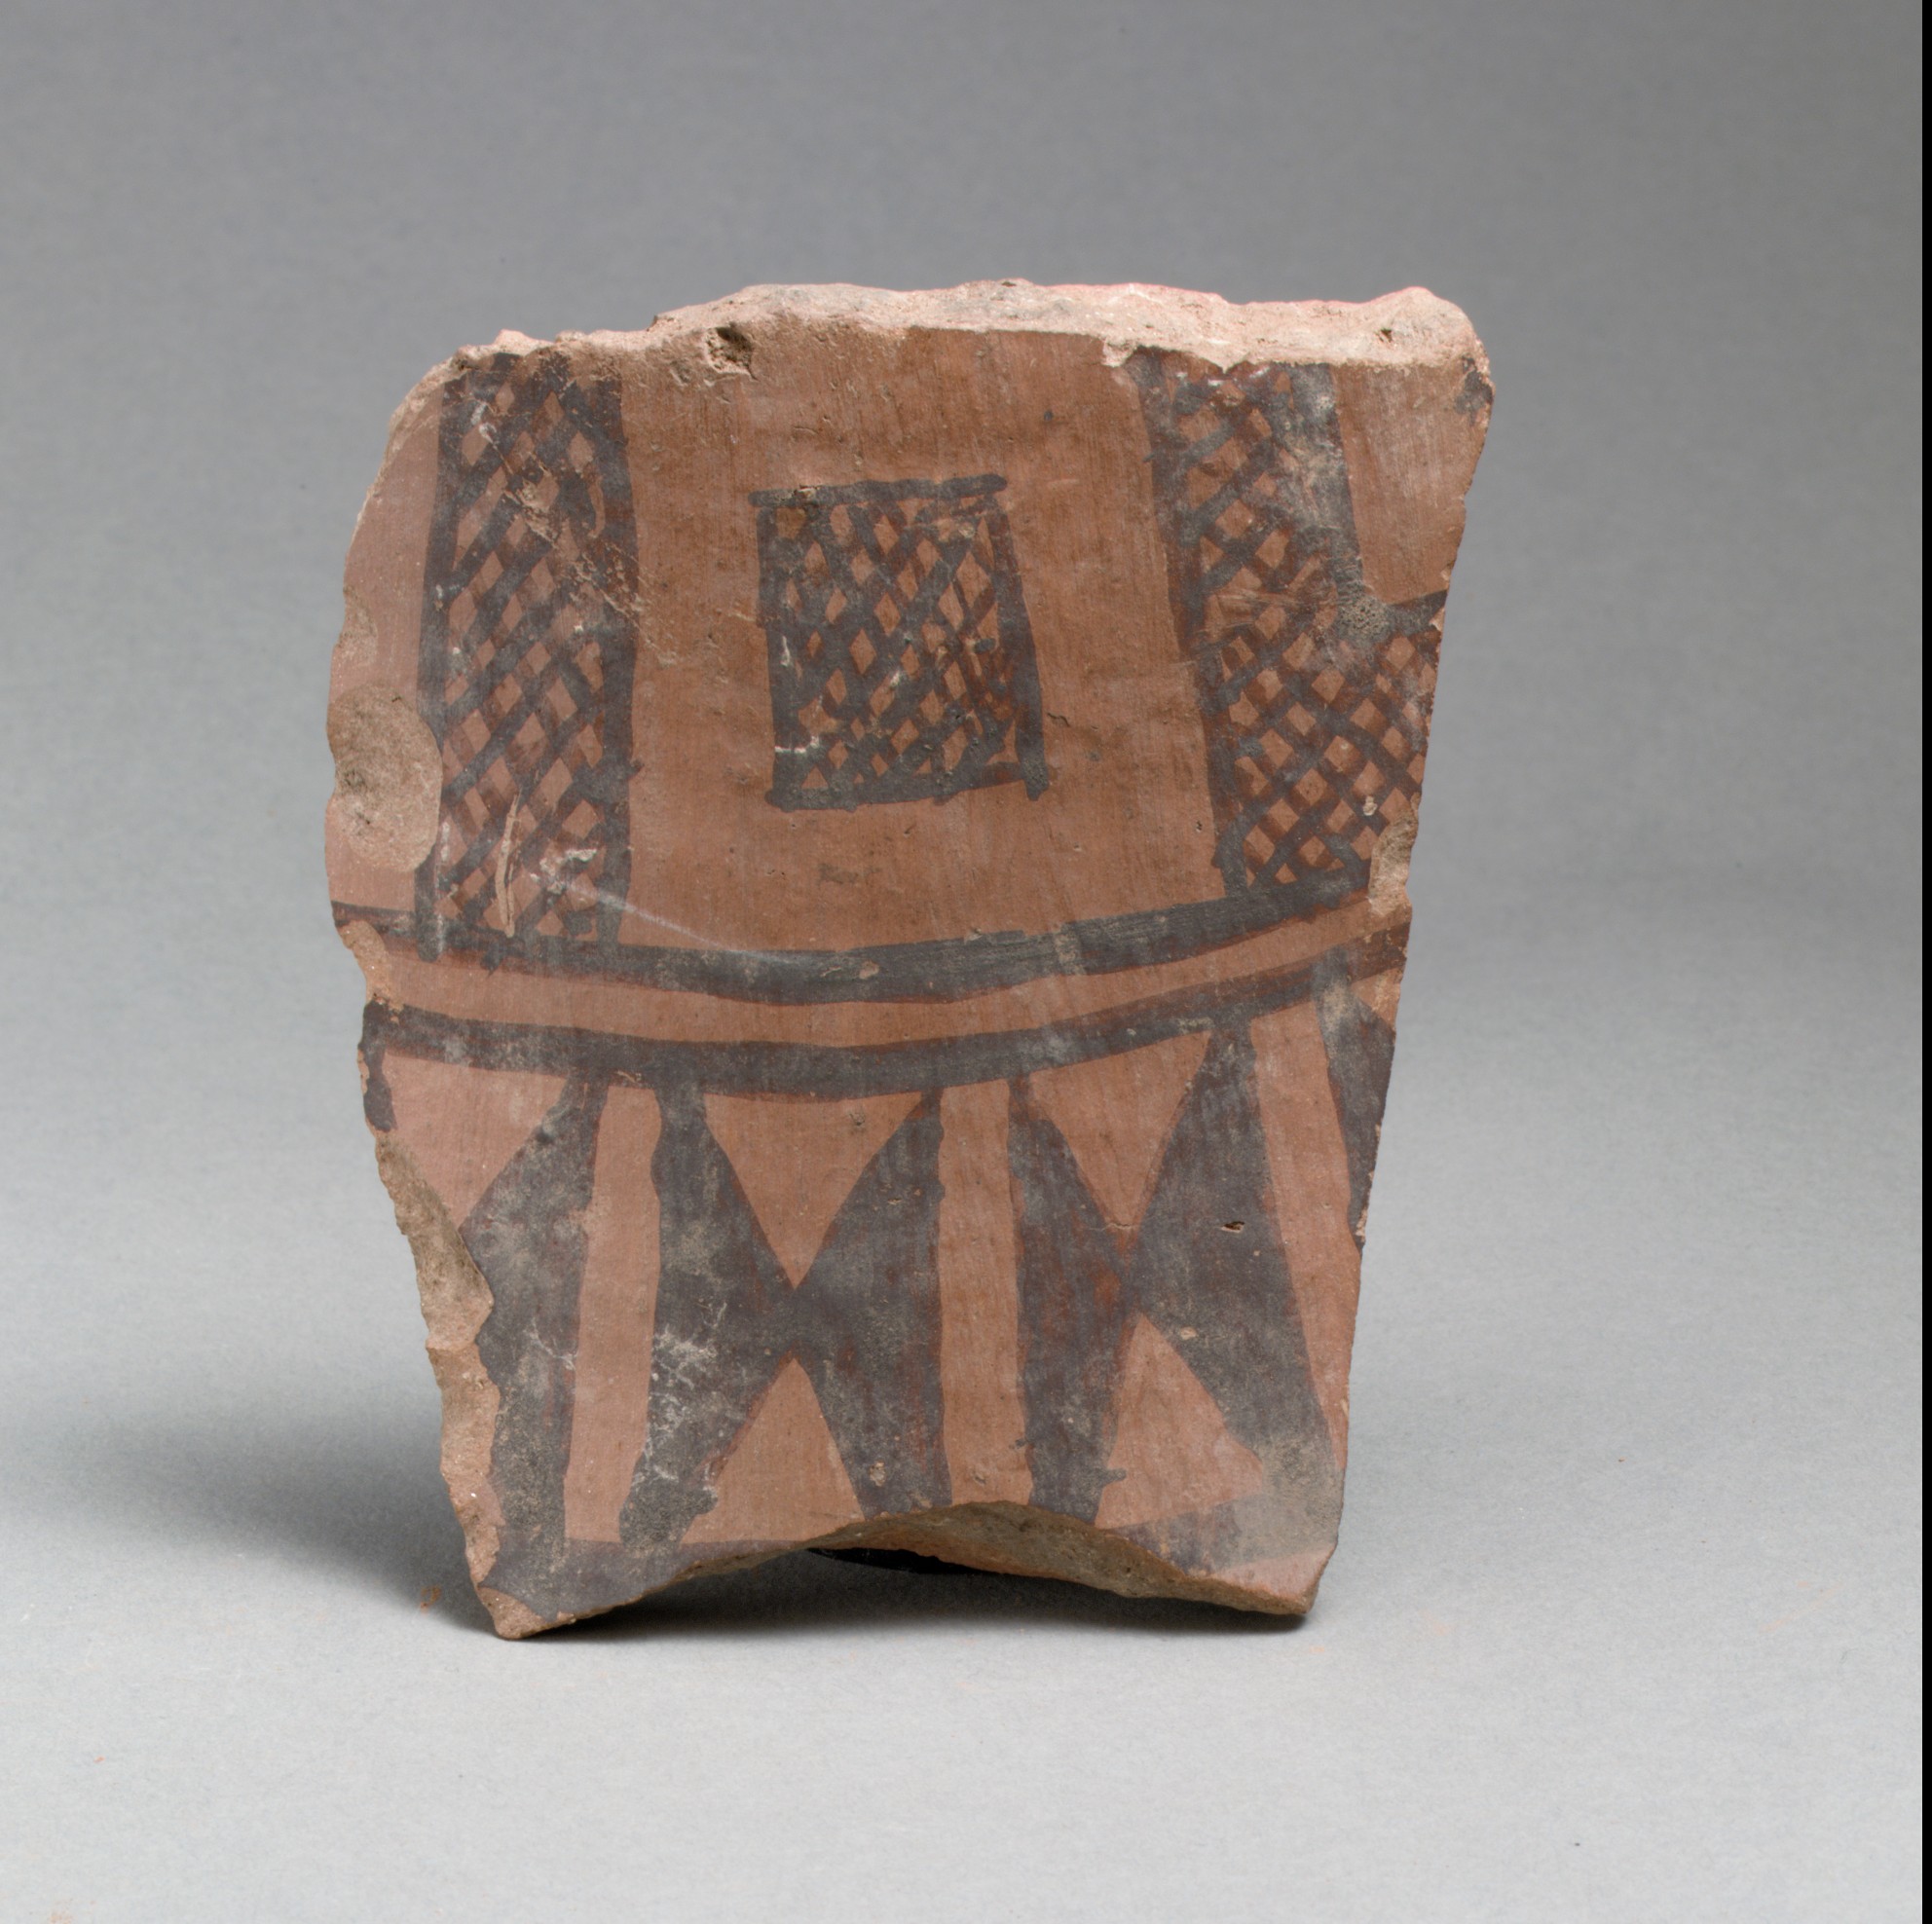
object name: vase fragment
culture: greek or lydian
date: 1050-700 BCE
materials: terracotta